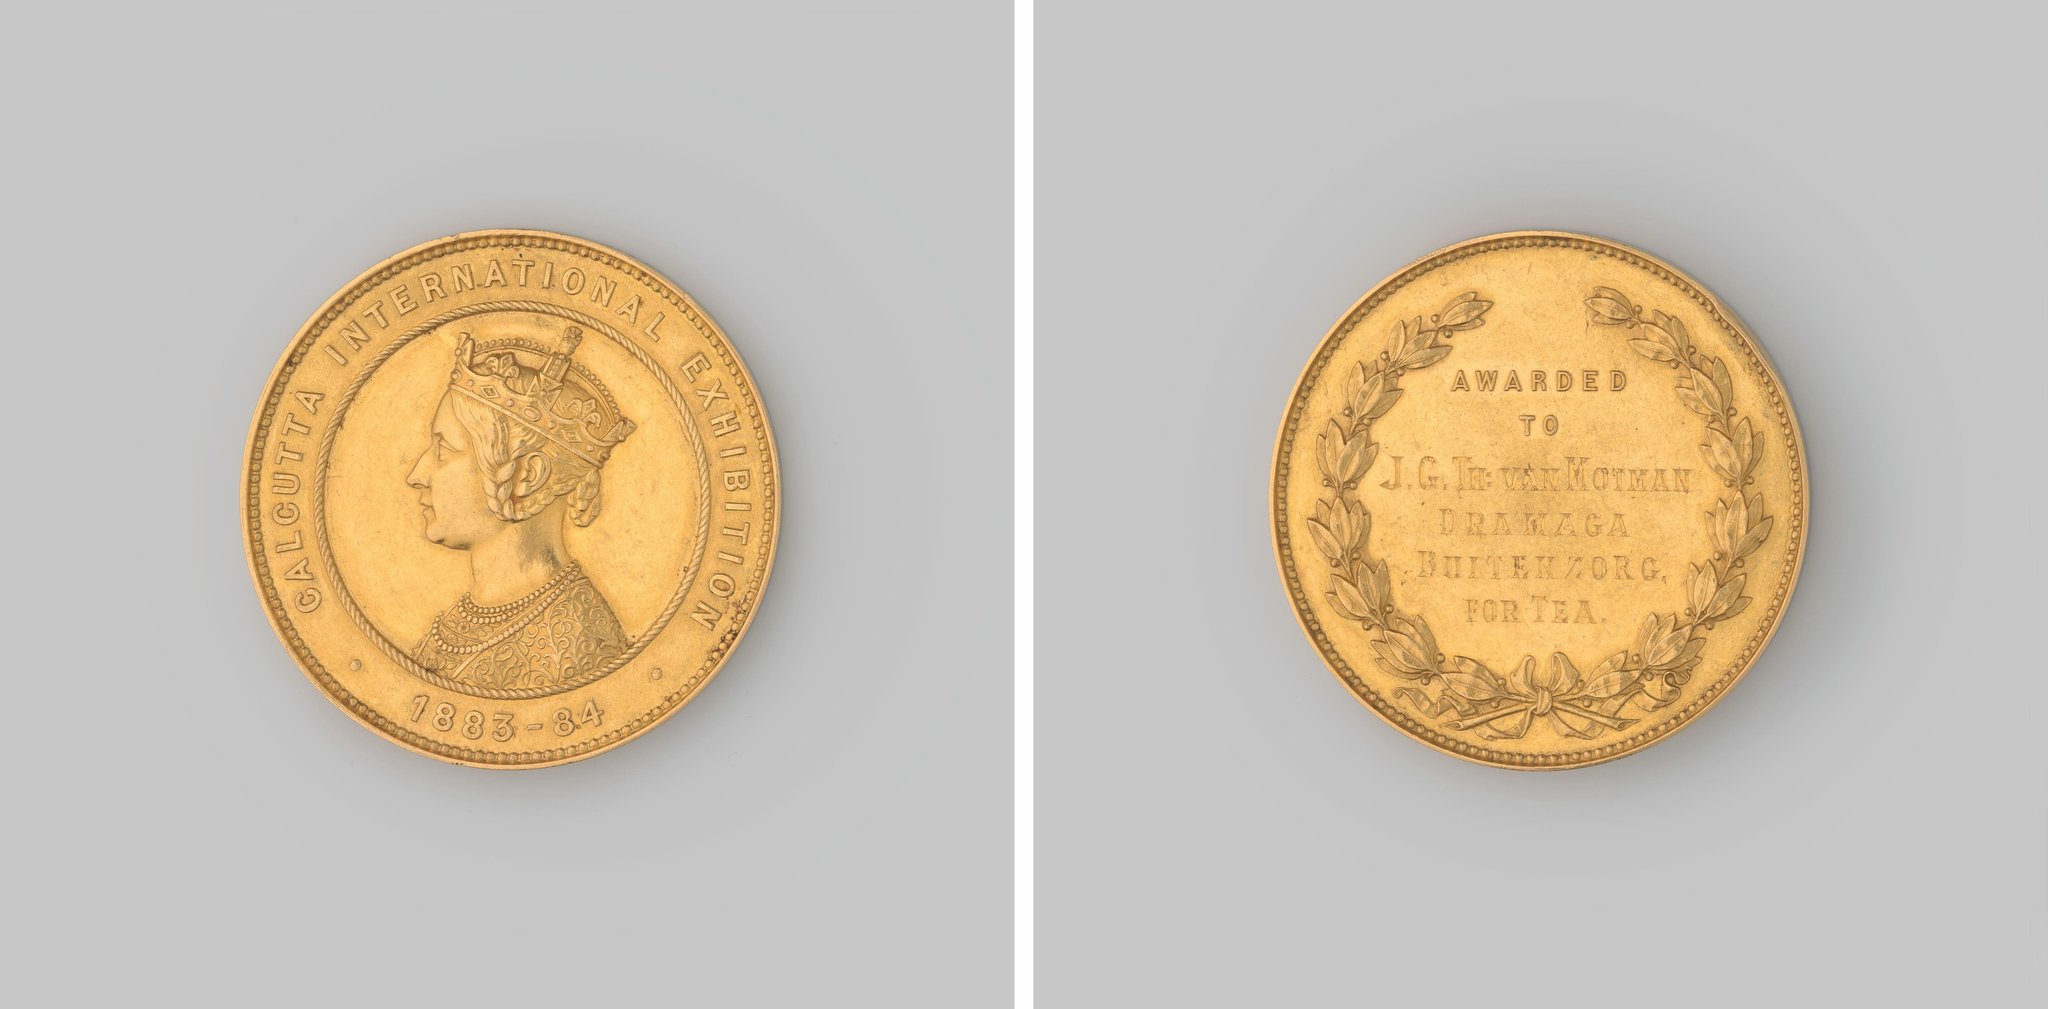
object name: medal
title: Honorary Medal of the Calcutta International Exhibition Awarded to J.G.Th. van Motman, Dramaga Plantaton (Buitenzorg, Dutch East Indies) for Tea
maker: Anonymous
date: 1883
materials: gold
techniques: engraving, striking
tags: victoria (koningin van het verenigd koninkrijk en keizerin van india)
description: The Rijksmuseum’s medal collection, boasting some 12,500 objects, is almost a century and a half old. The museum continues to expand its collection with special medals, which are either purchased, donated, or given on loan. On display here are a number of the most extraordinary acquisitions of recent years. These are honorary and commemorative medals. Several are unique and came from the descendants of the individuals who once received them.